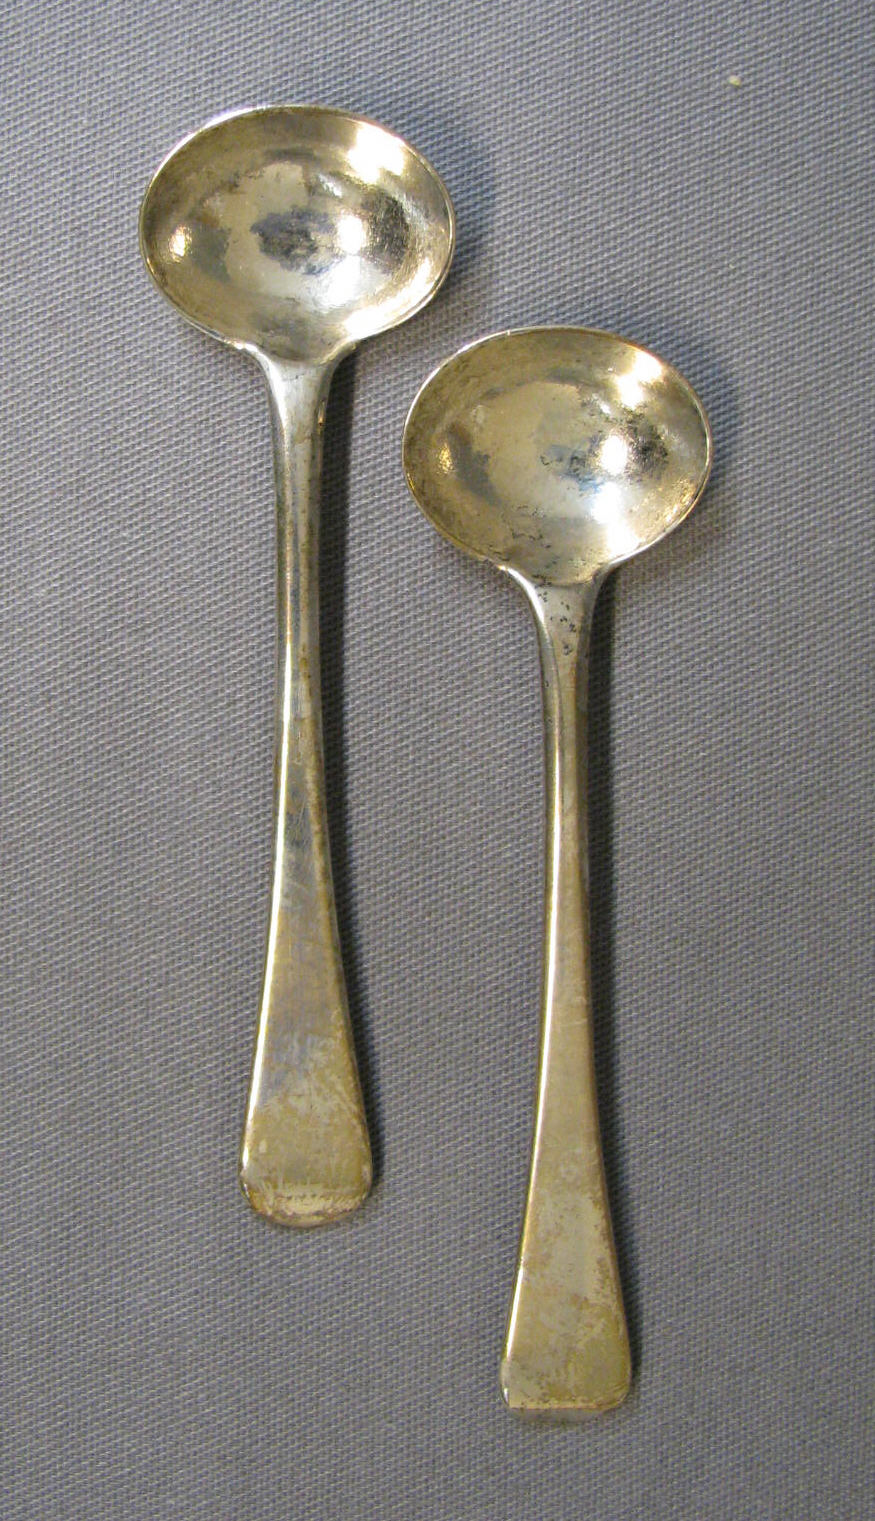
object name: salt spoon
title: Two salt spoons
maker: james ede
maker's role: maker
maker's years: 1808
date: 1808-1809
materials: silver